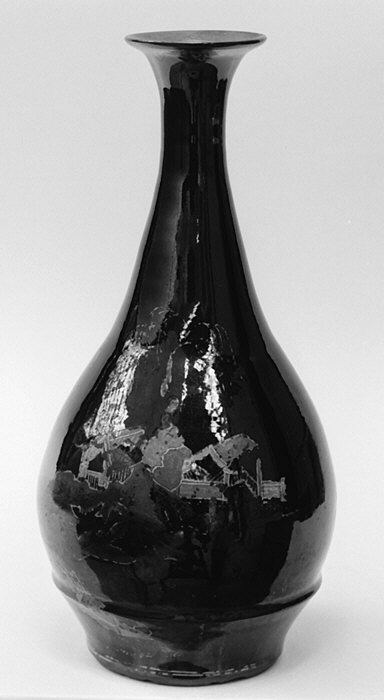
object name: bottle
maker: meissen manufactory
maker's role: manufactory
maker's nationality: german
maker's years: 1710-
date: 1712-1713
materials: glaze, lacquer, stoneware